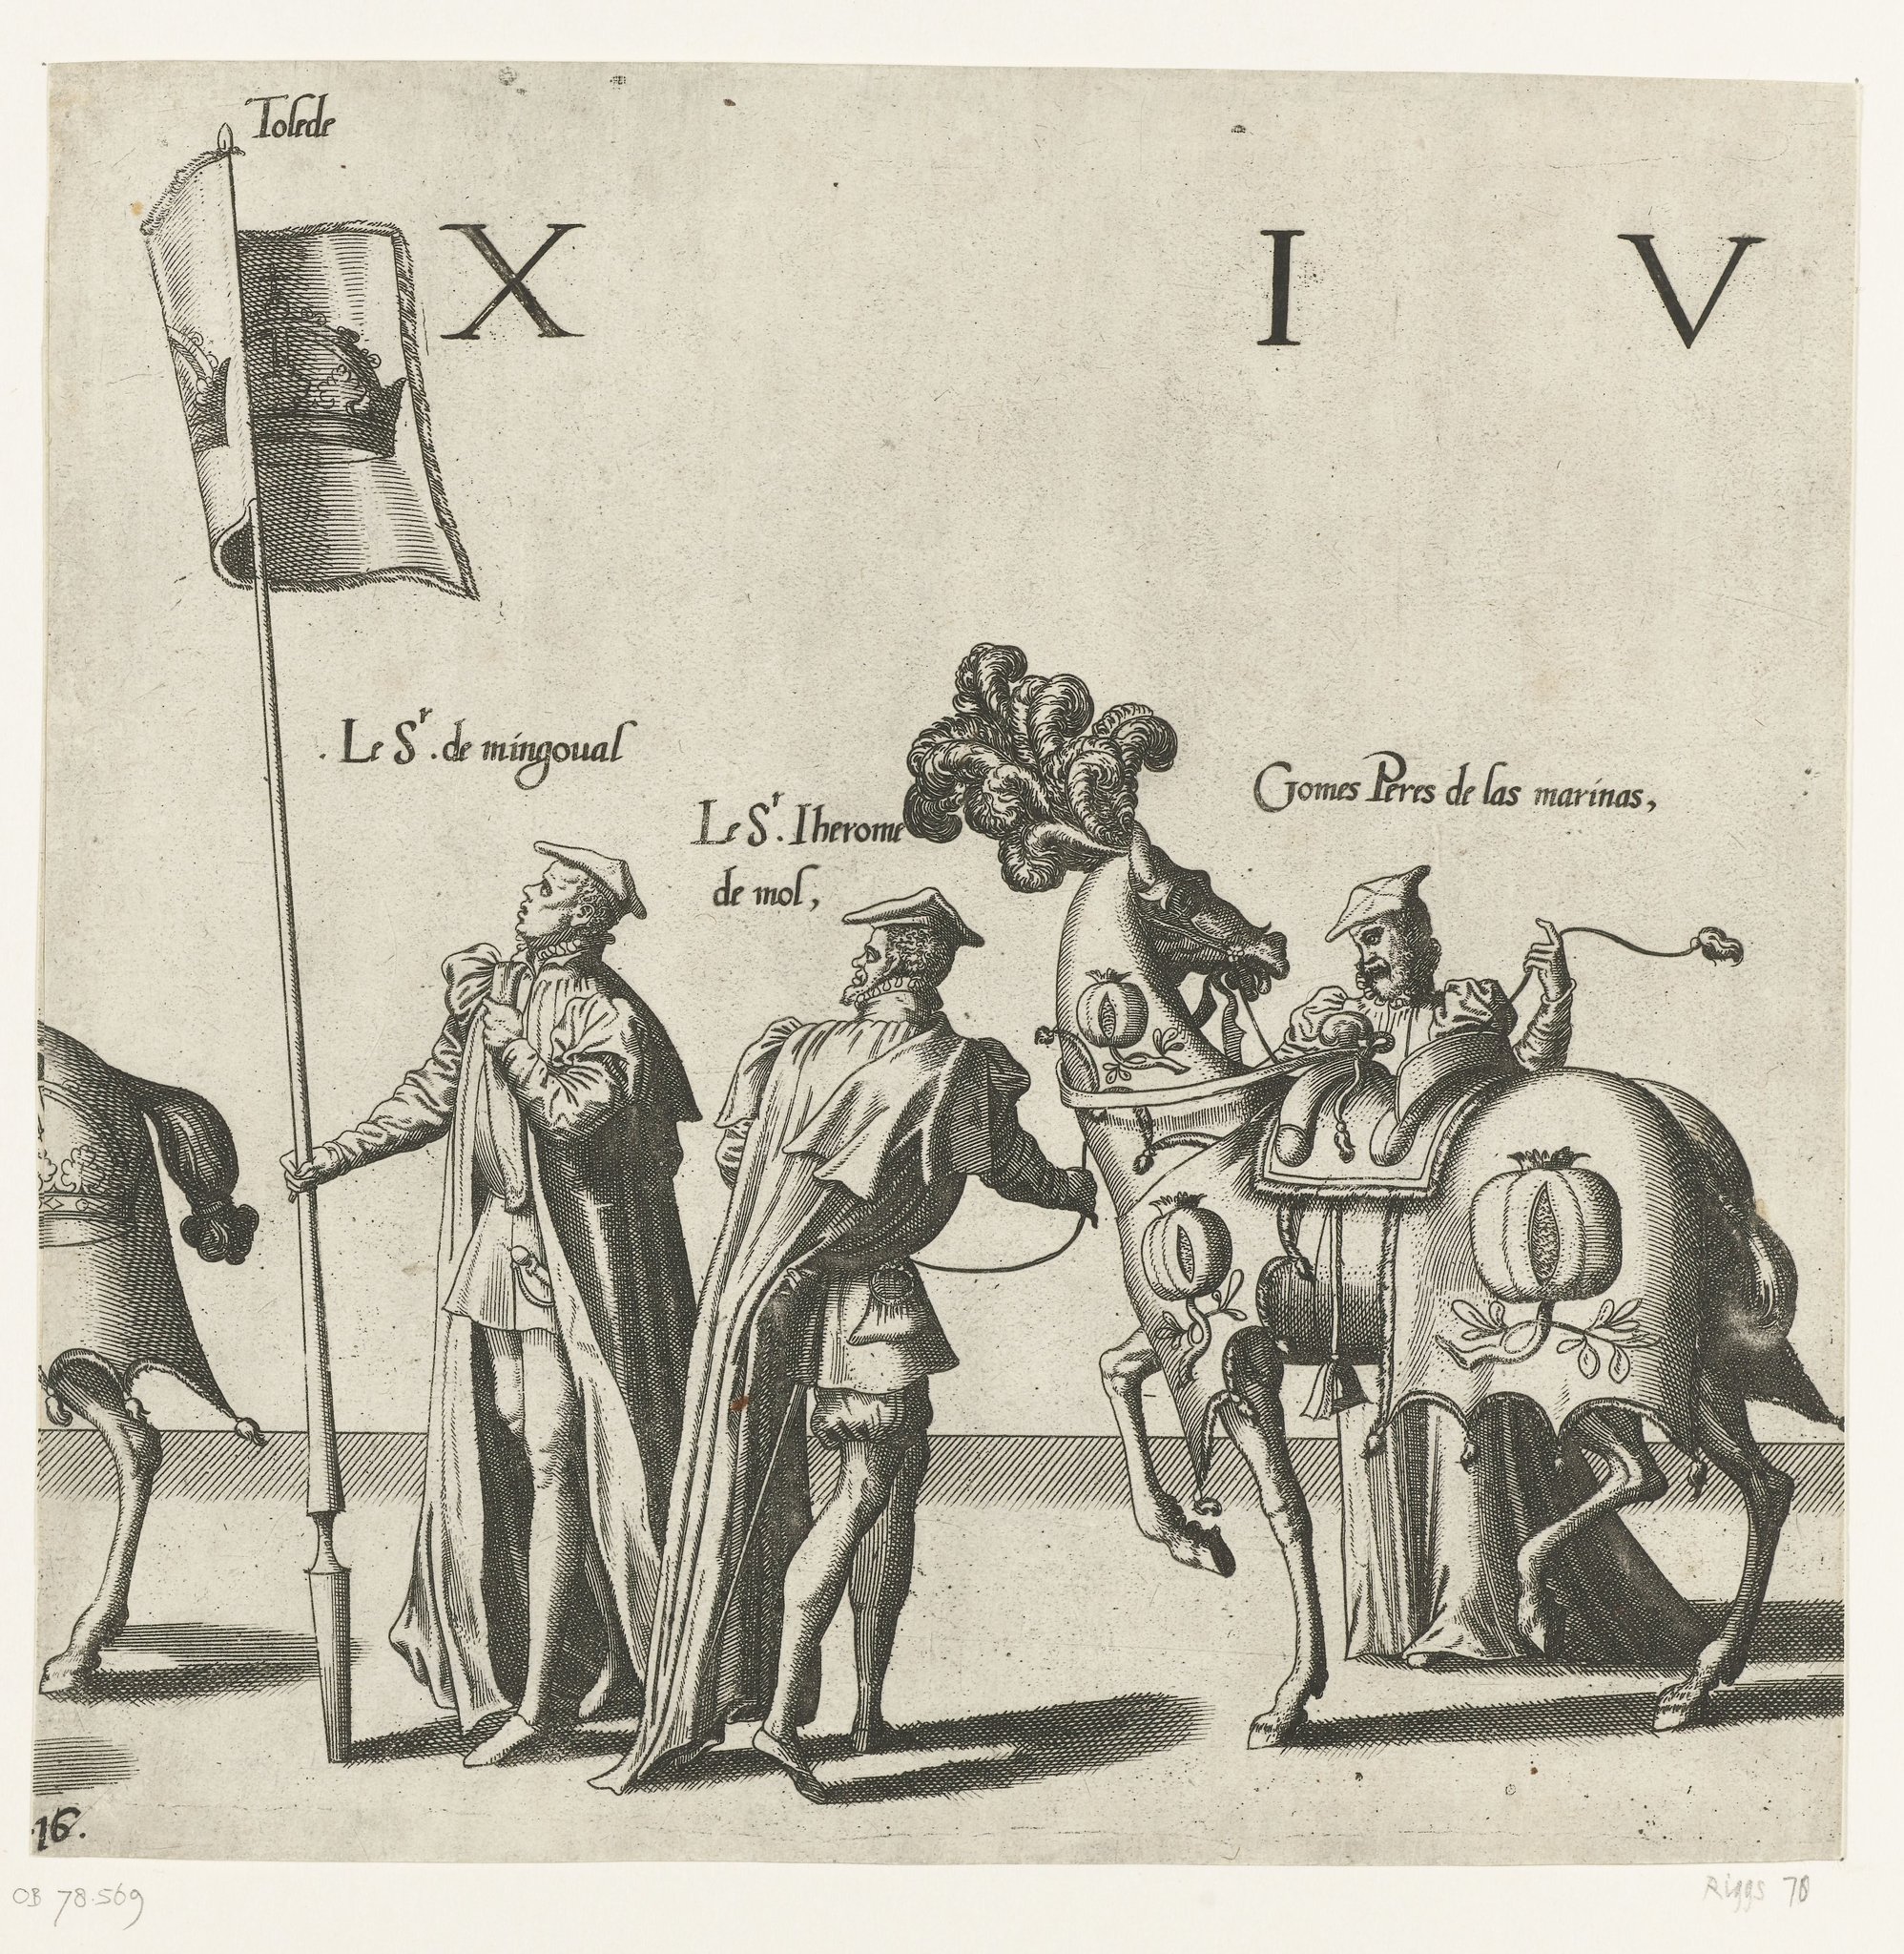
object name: print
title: Deel van de optocht, nr. 16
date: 1559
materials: paper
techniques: engraving, etching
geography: southern netherlands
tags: ghent, charles v (holy roman emperor and king of spain), cortege, funeral procession, brussels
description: Drie deelnemers aan de optocht, paarden en het vaandel met het wapen van Toledo. Onderdeel van de prentreeks van de Begrafenisoptocht van keizer Karel V op 29 december 1558 te Brussel.